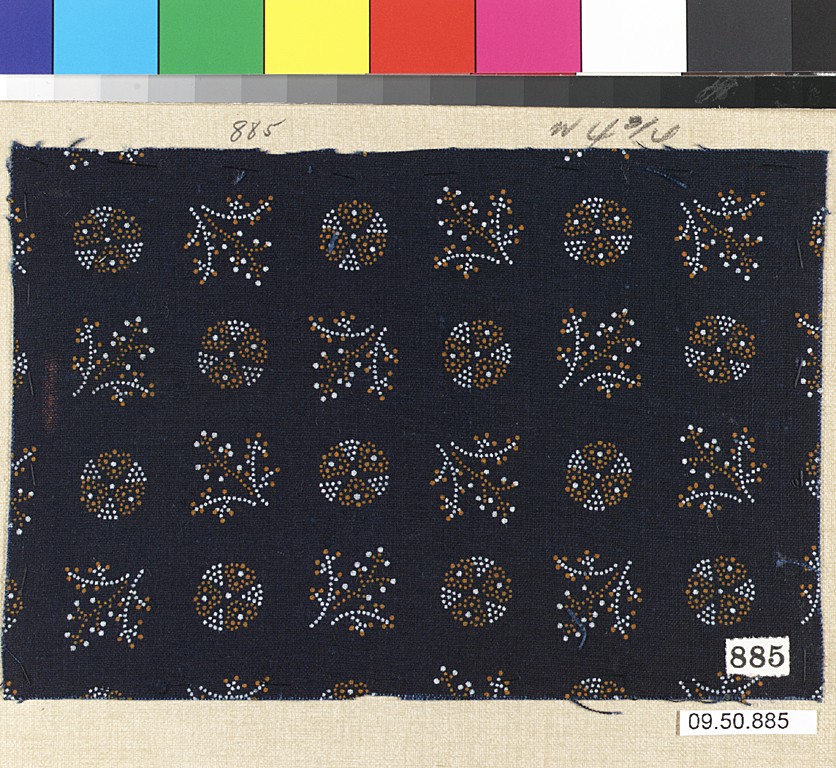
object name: piece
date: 1801-1900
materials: cotton